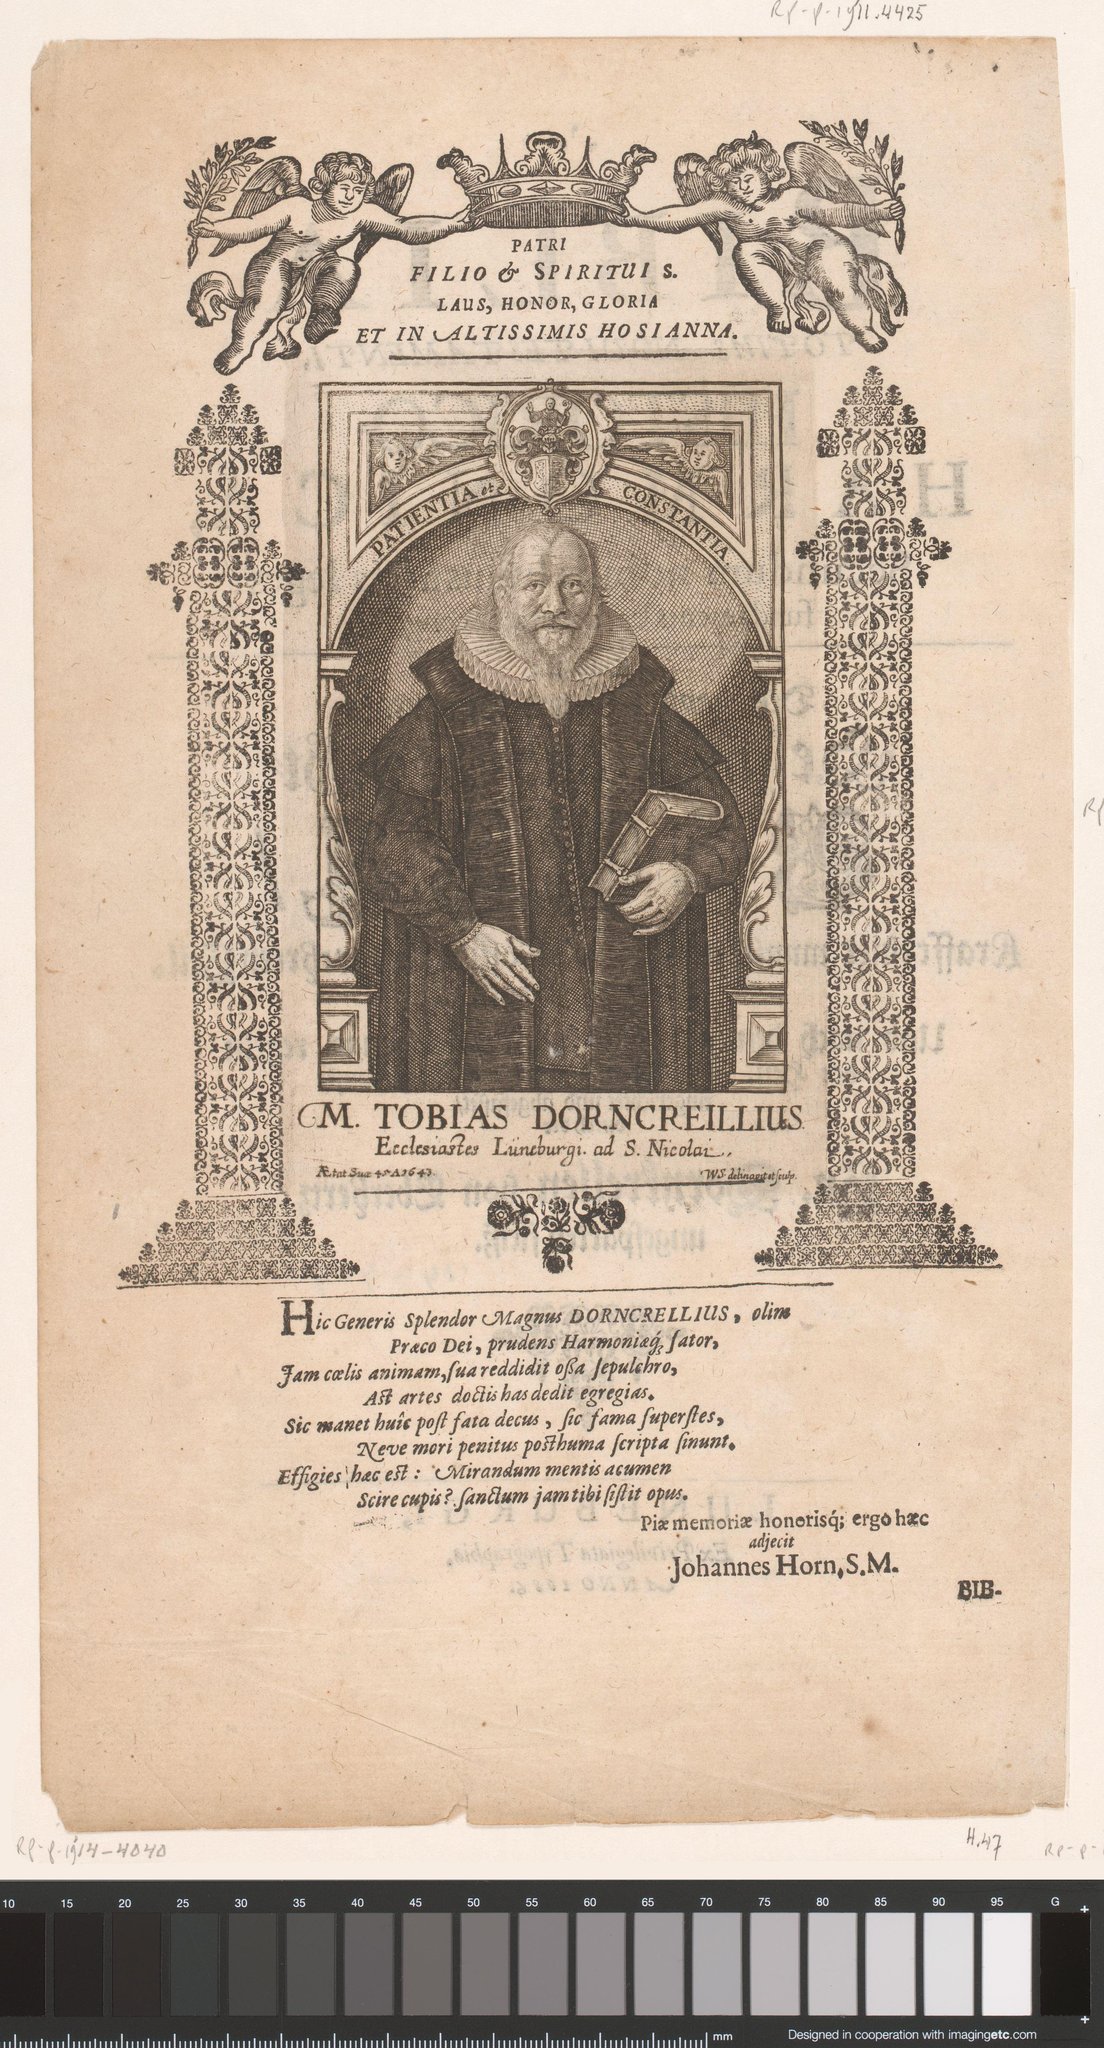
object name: print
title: Portret van Tobias Dornkrell von Eberherz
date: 1685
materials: paper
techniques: engraving, letterpress printing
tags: historical persons, armorial bearing, heraldry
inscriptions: collector's mark: Lugt 2228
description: Prent afkomstig uit: Dornkrell von Eberherz, Tobias. Biblia et historico-harmonica (...). Lüneburg: Jacob Dornkrell ab Eberhertz, 1685.